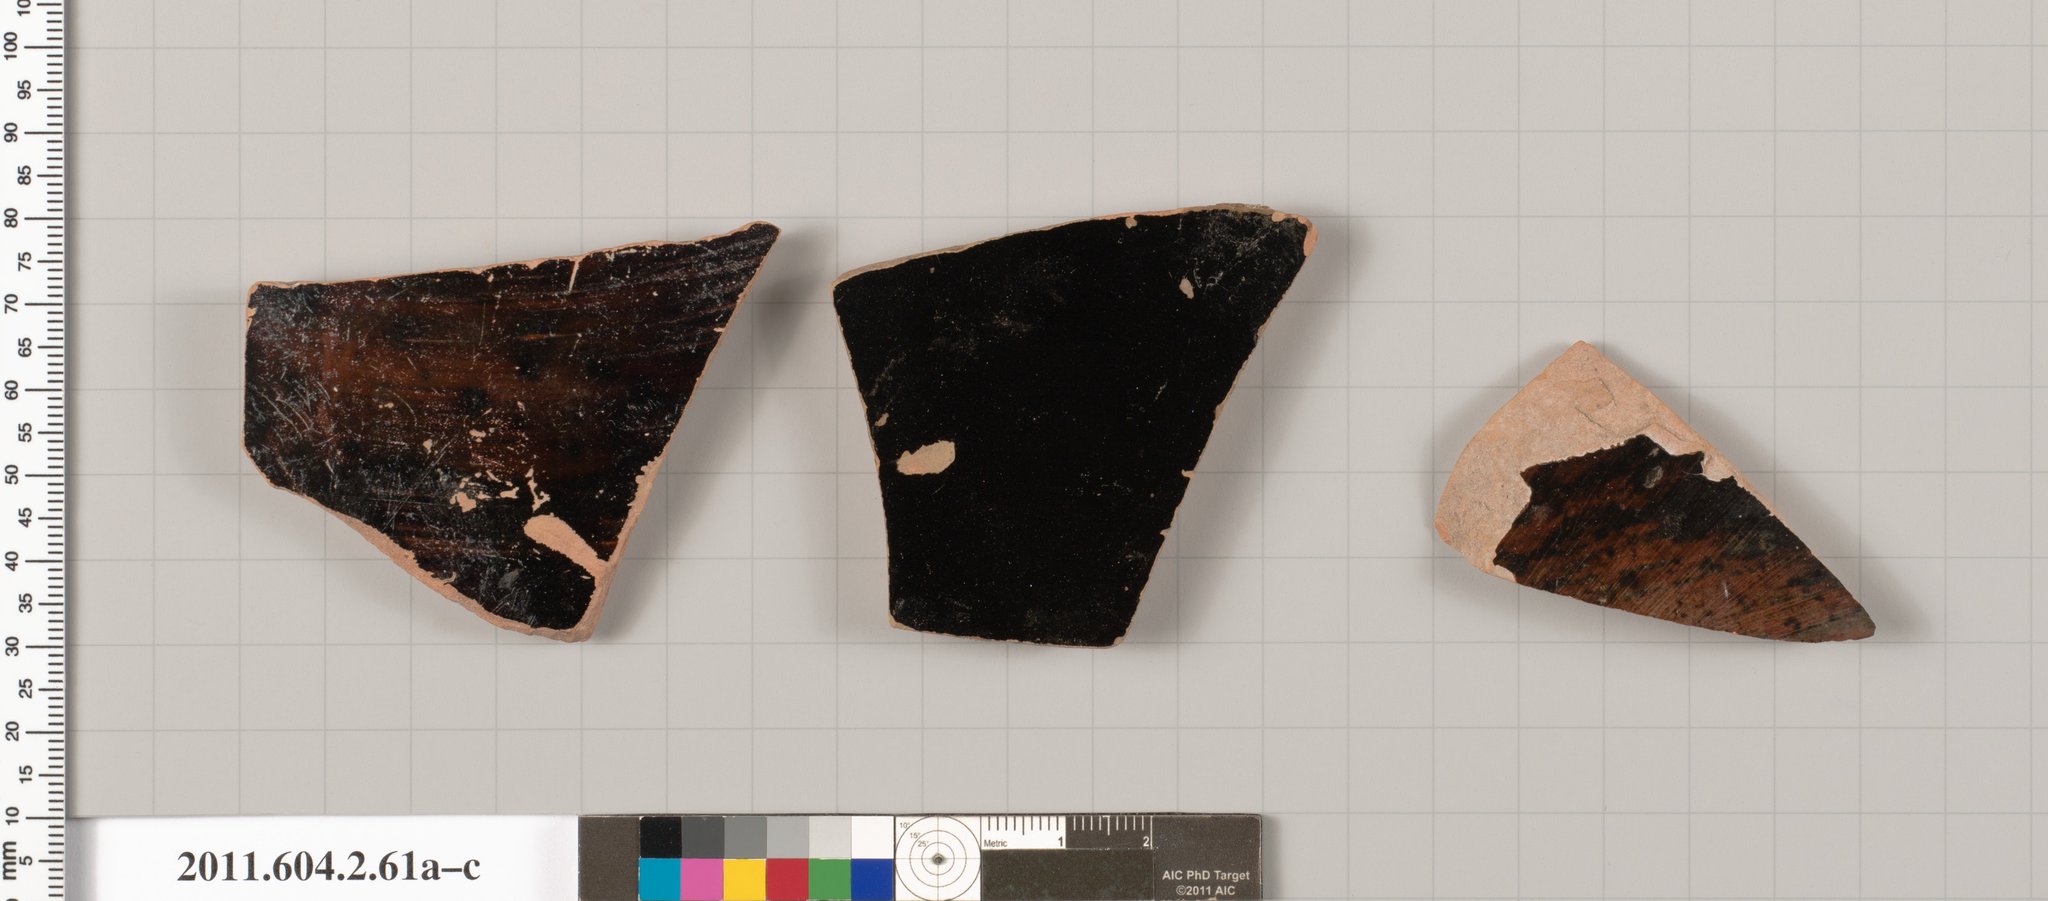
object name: pot fragment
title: Terracotta fragments of pots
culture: greek, attic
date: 534-468 BCE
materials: terracotta